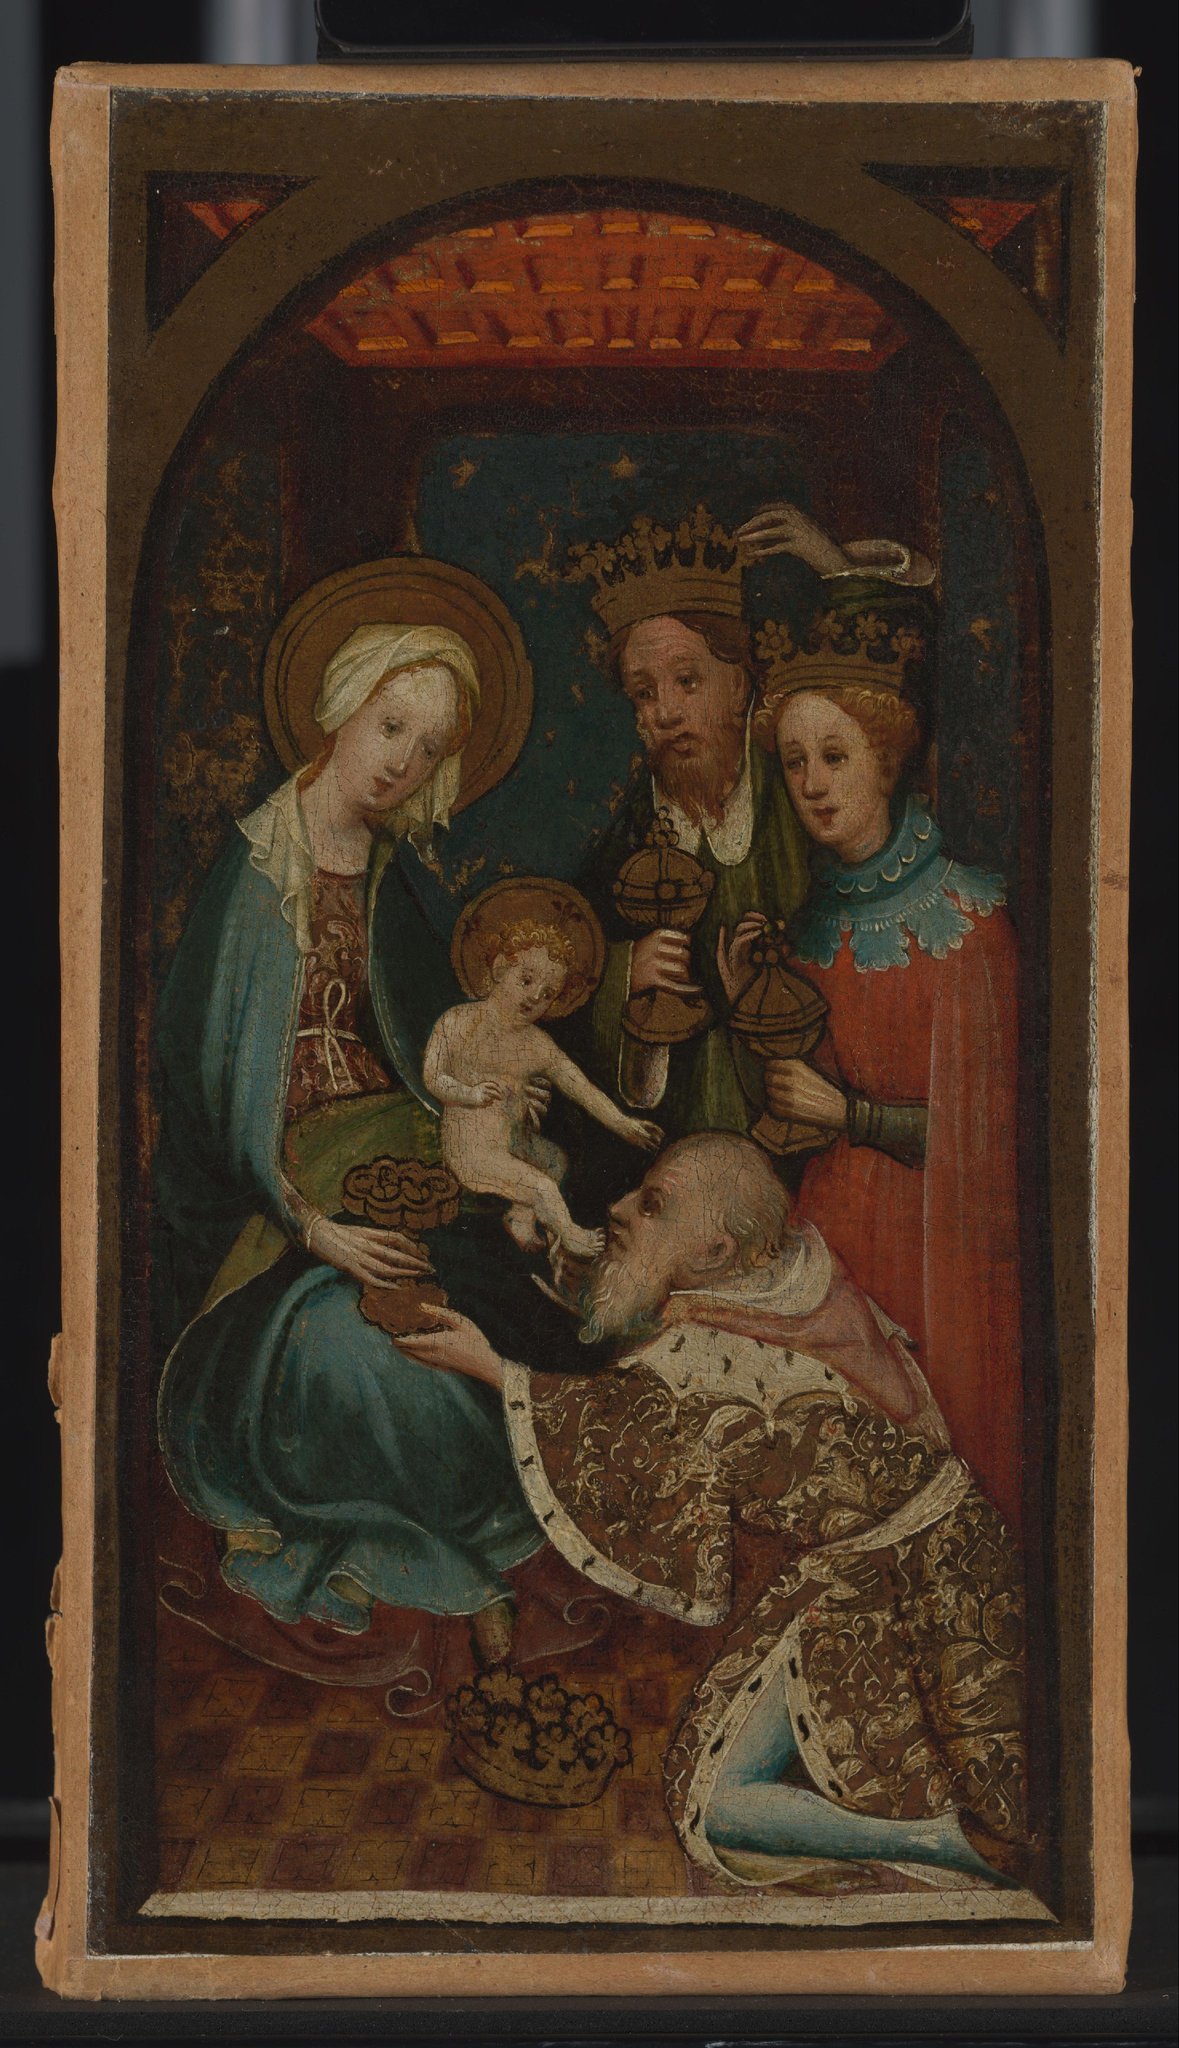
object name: painting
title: The Adoration of the Magi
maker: Anonymous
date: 1410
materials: canvas, oil, paint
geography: cologne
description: The oldest of the three kings kneels reverently before the new-born Christ child whilst kissing his foot and presenting the Virgin Mary with a gold goblet. The middle-aged king, in the centre, is removing his crown as a sign of devotion. This adoration is a fragment of what was originally a much larger canvas containing scenes from the life and passion of Christ.